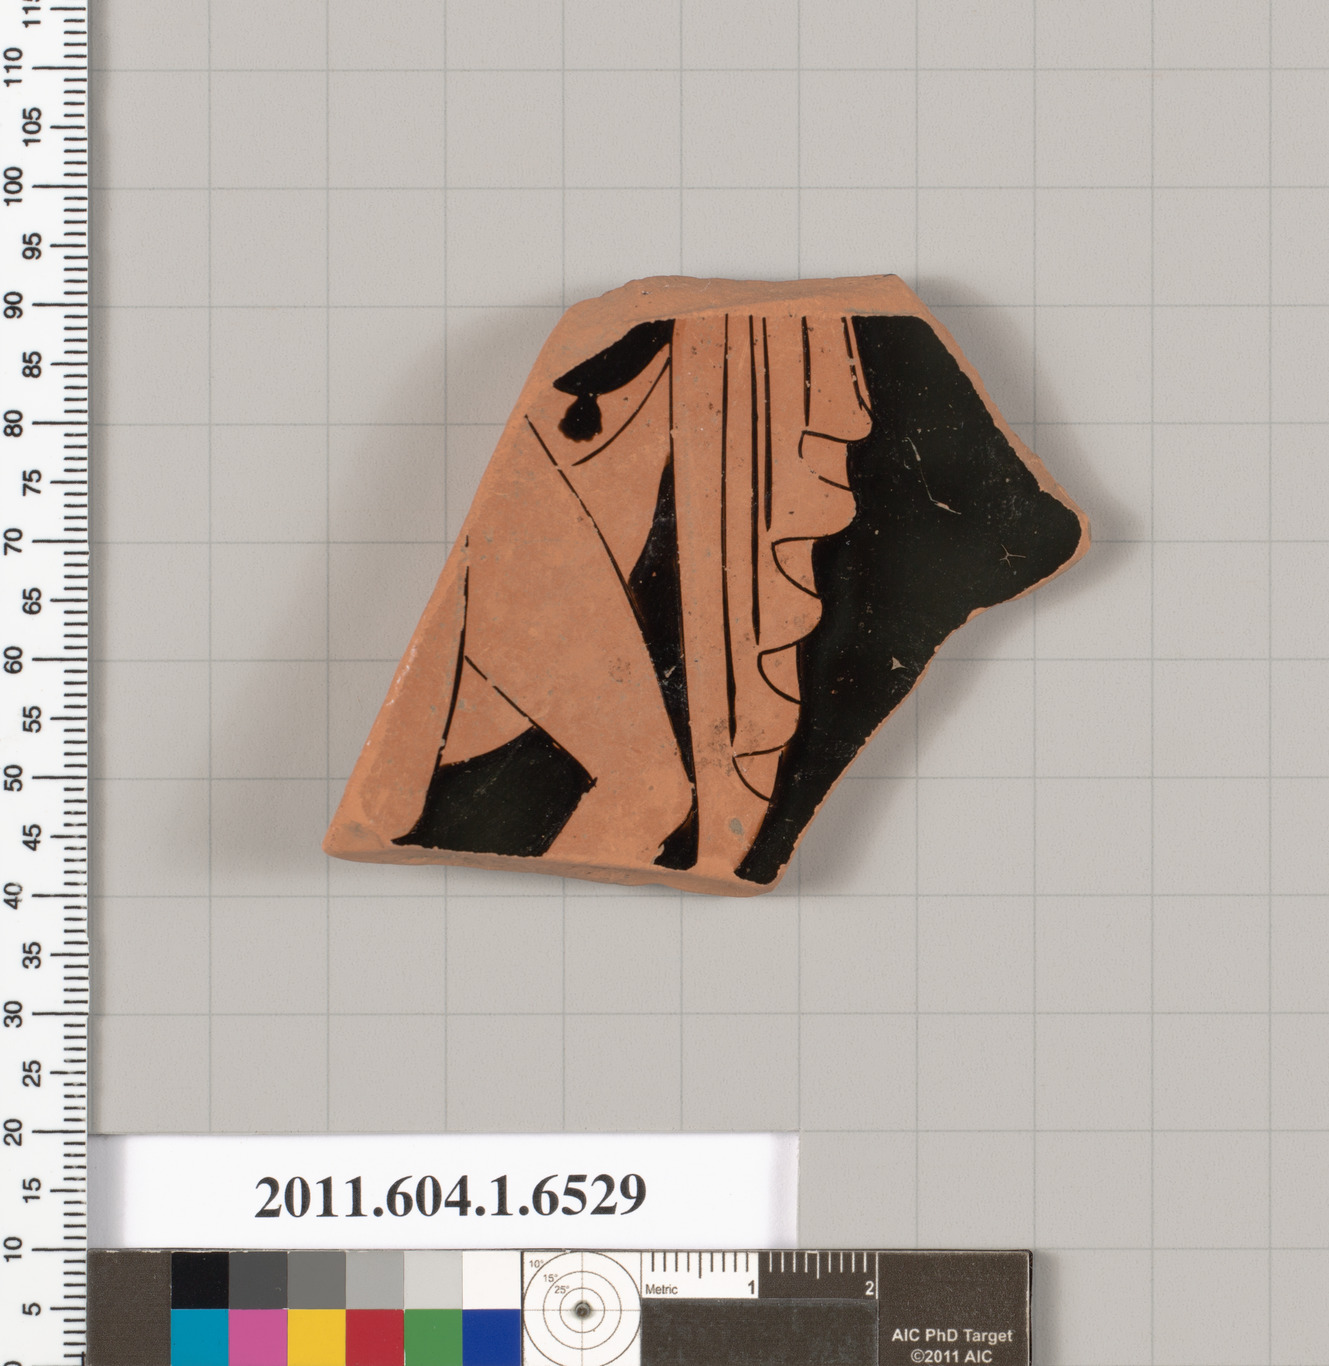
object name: kylix fragment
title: Terracotta fragment of a kylix (drinking cup)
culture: greek, attic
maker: colmar painter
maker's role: artist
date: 490-480 BCE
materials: terracotta